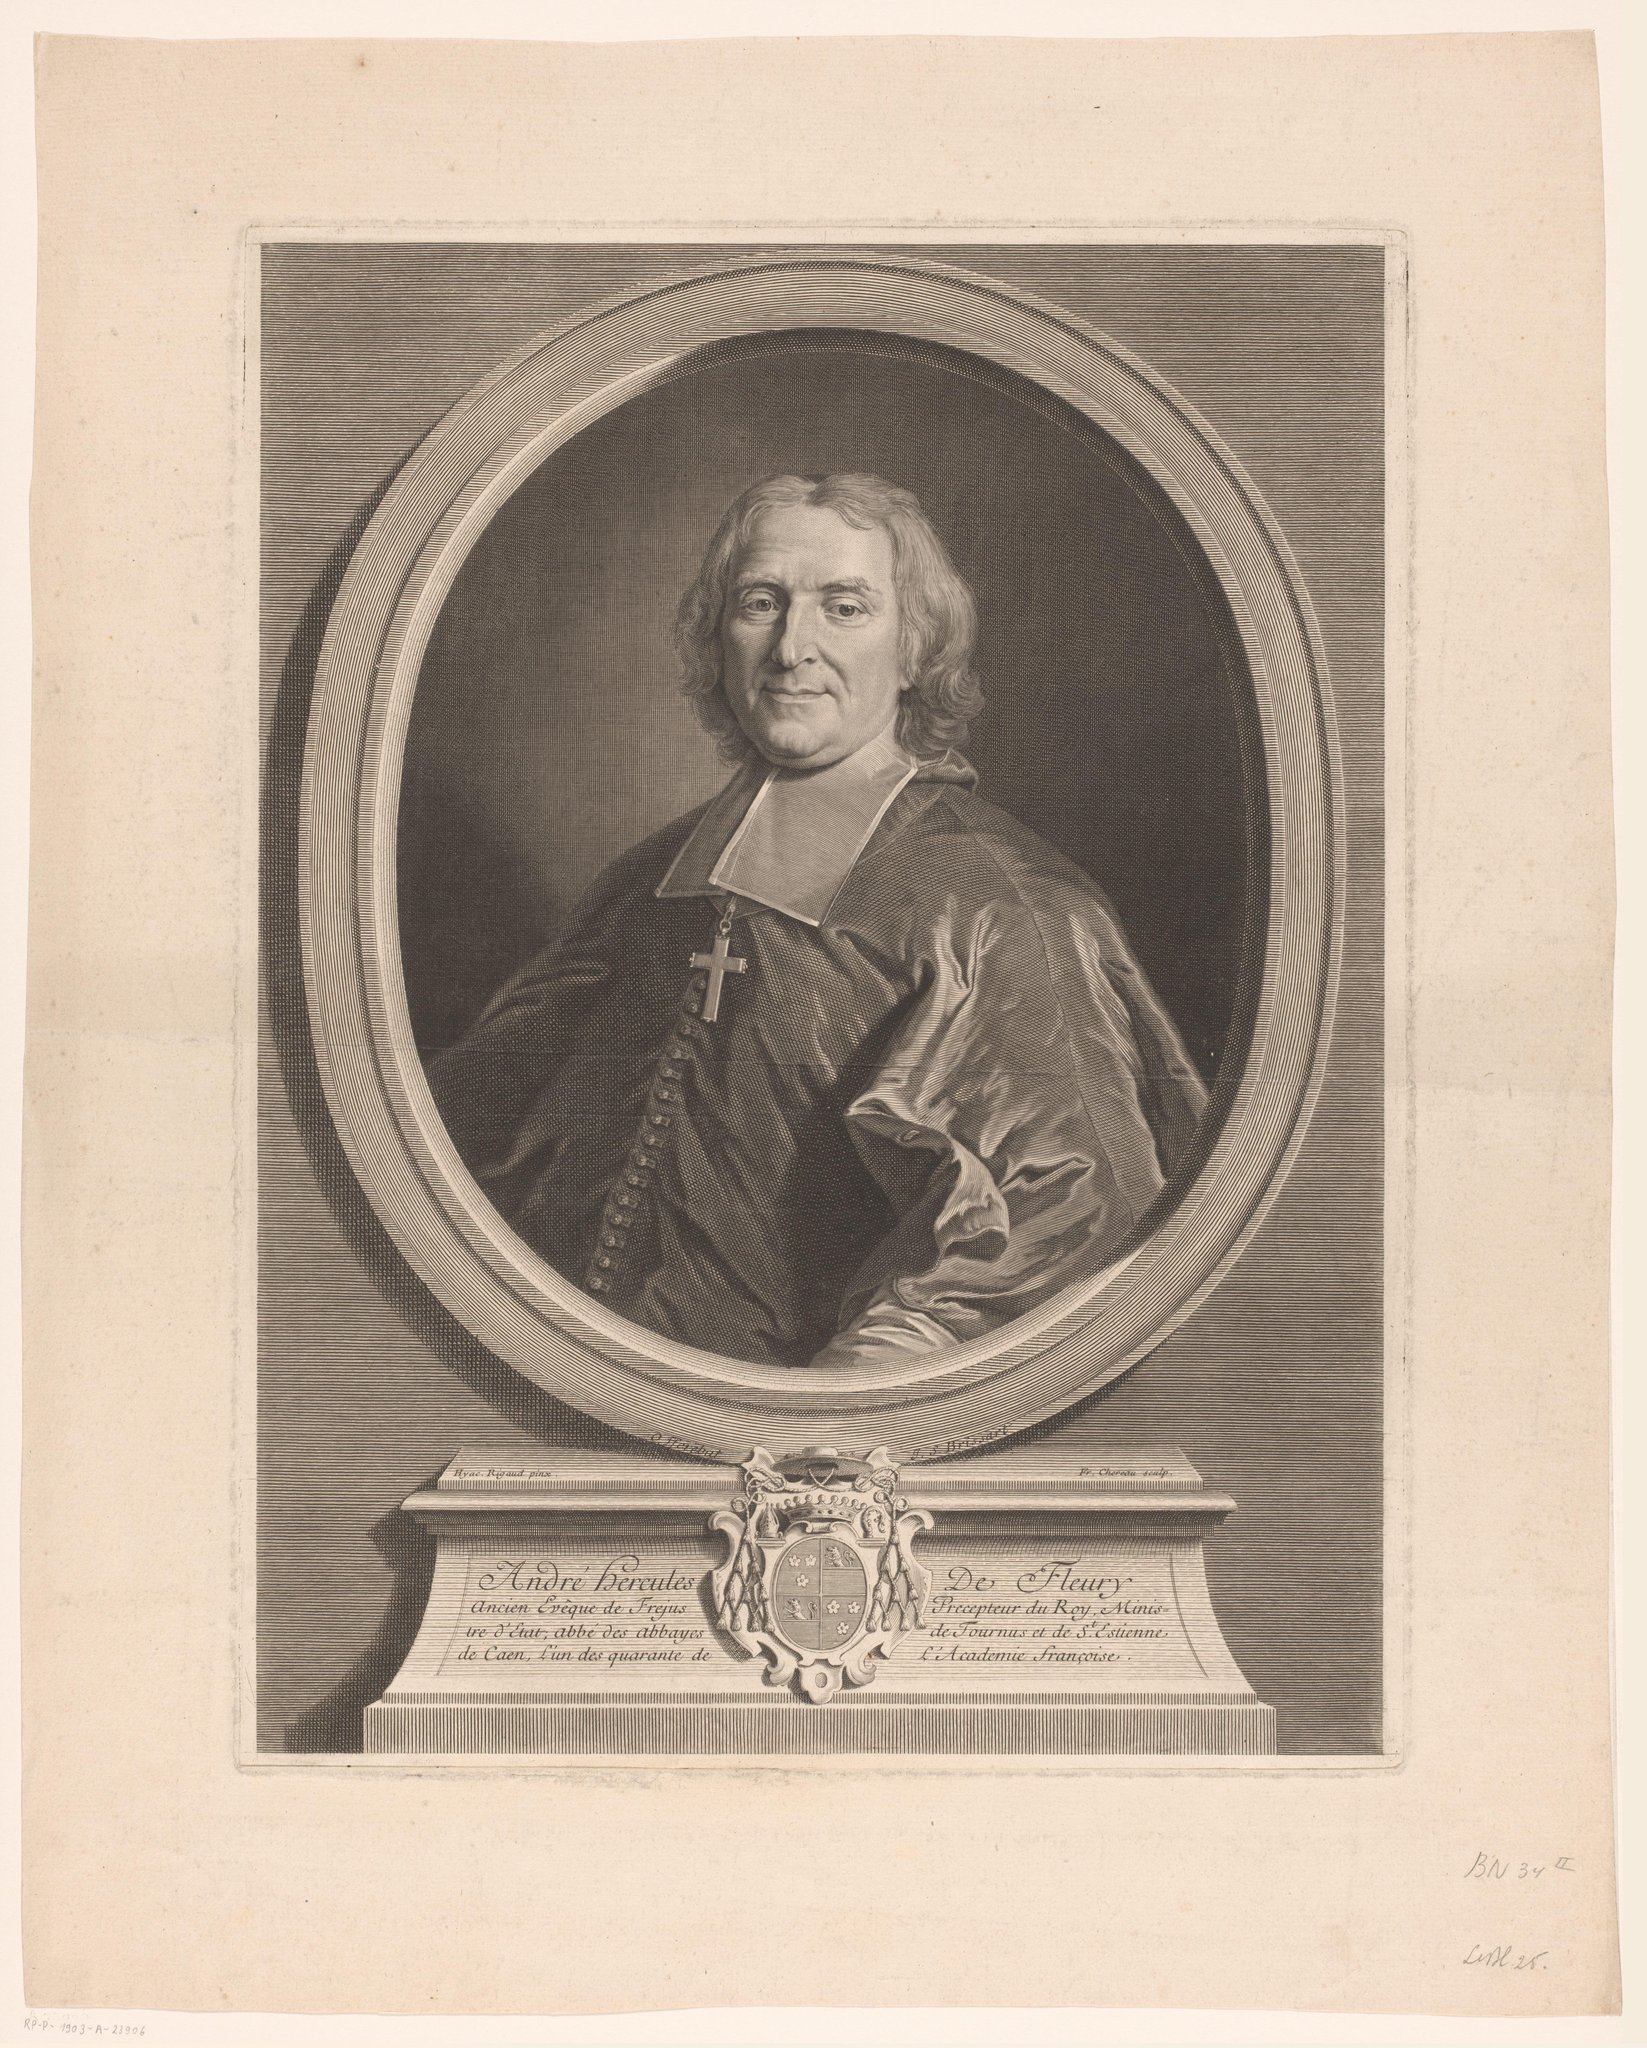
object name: print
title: André Hercules De Fleury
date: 1728-1729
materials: paper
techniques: engraving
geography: france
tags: ornament ~ medallion, historical persons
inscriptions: collector's mark: Lugt 2228